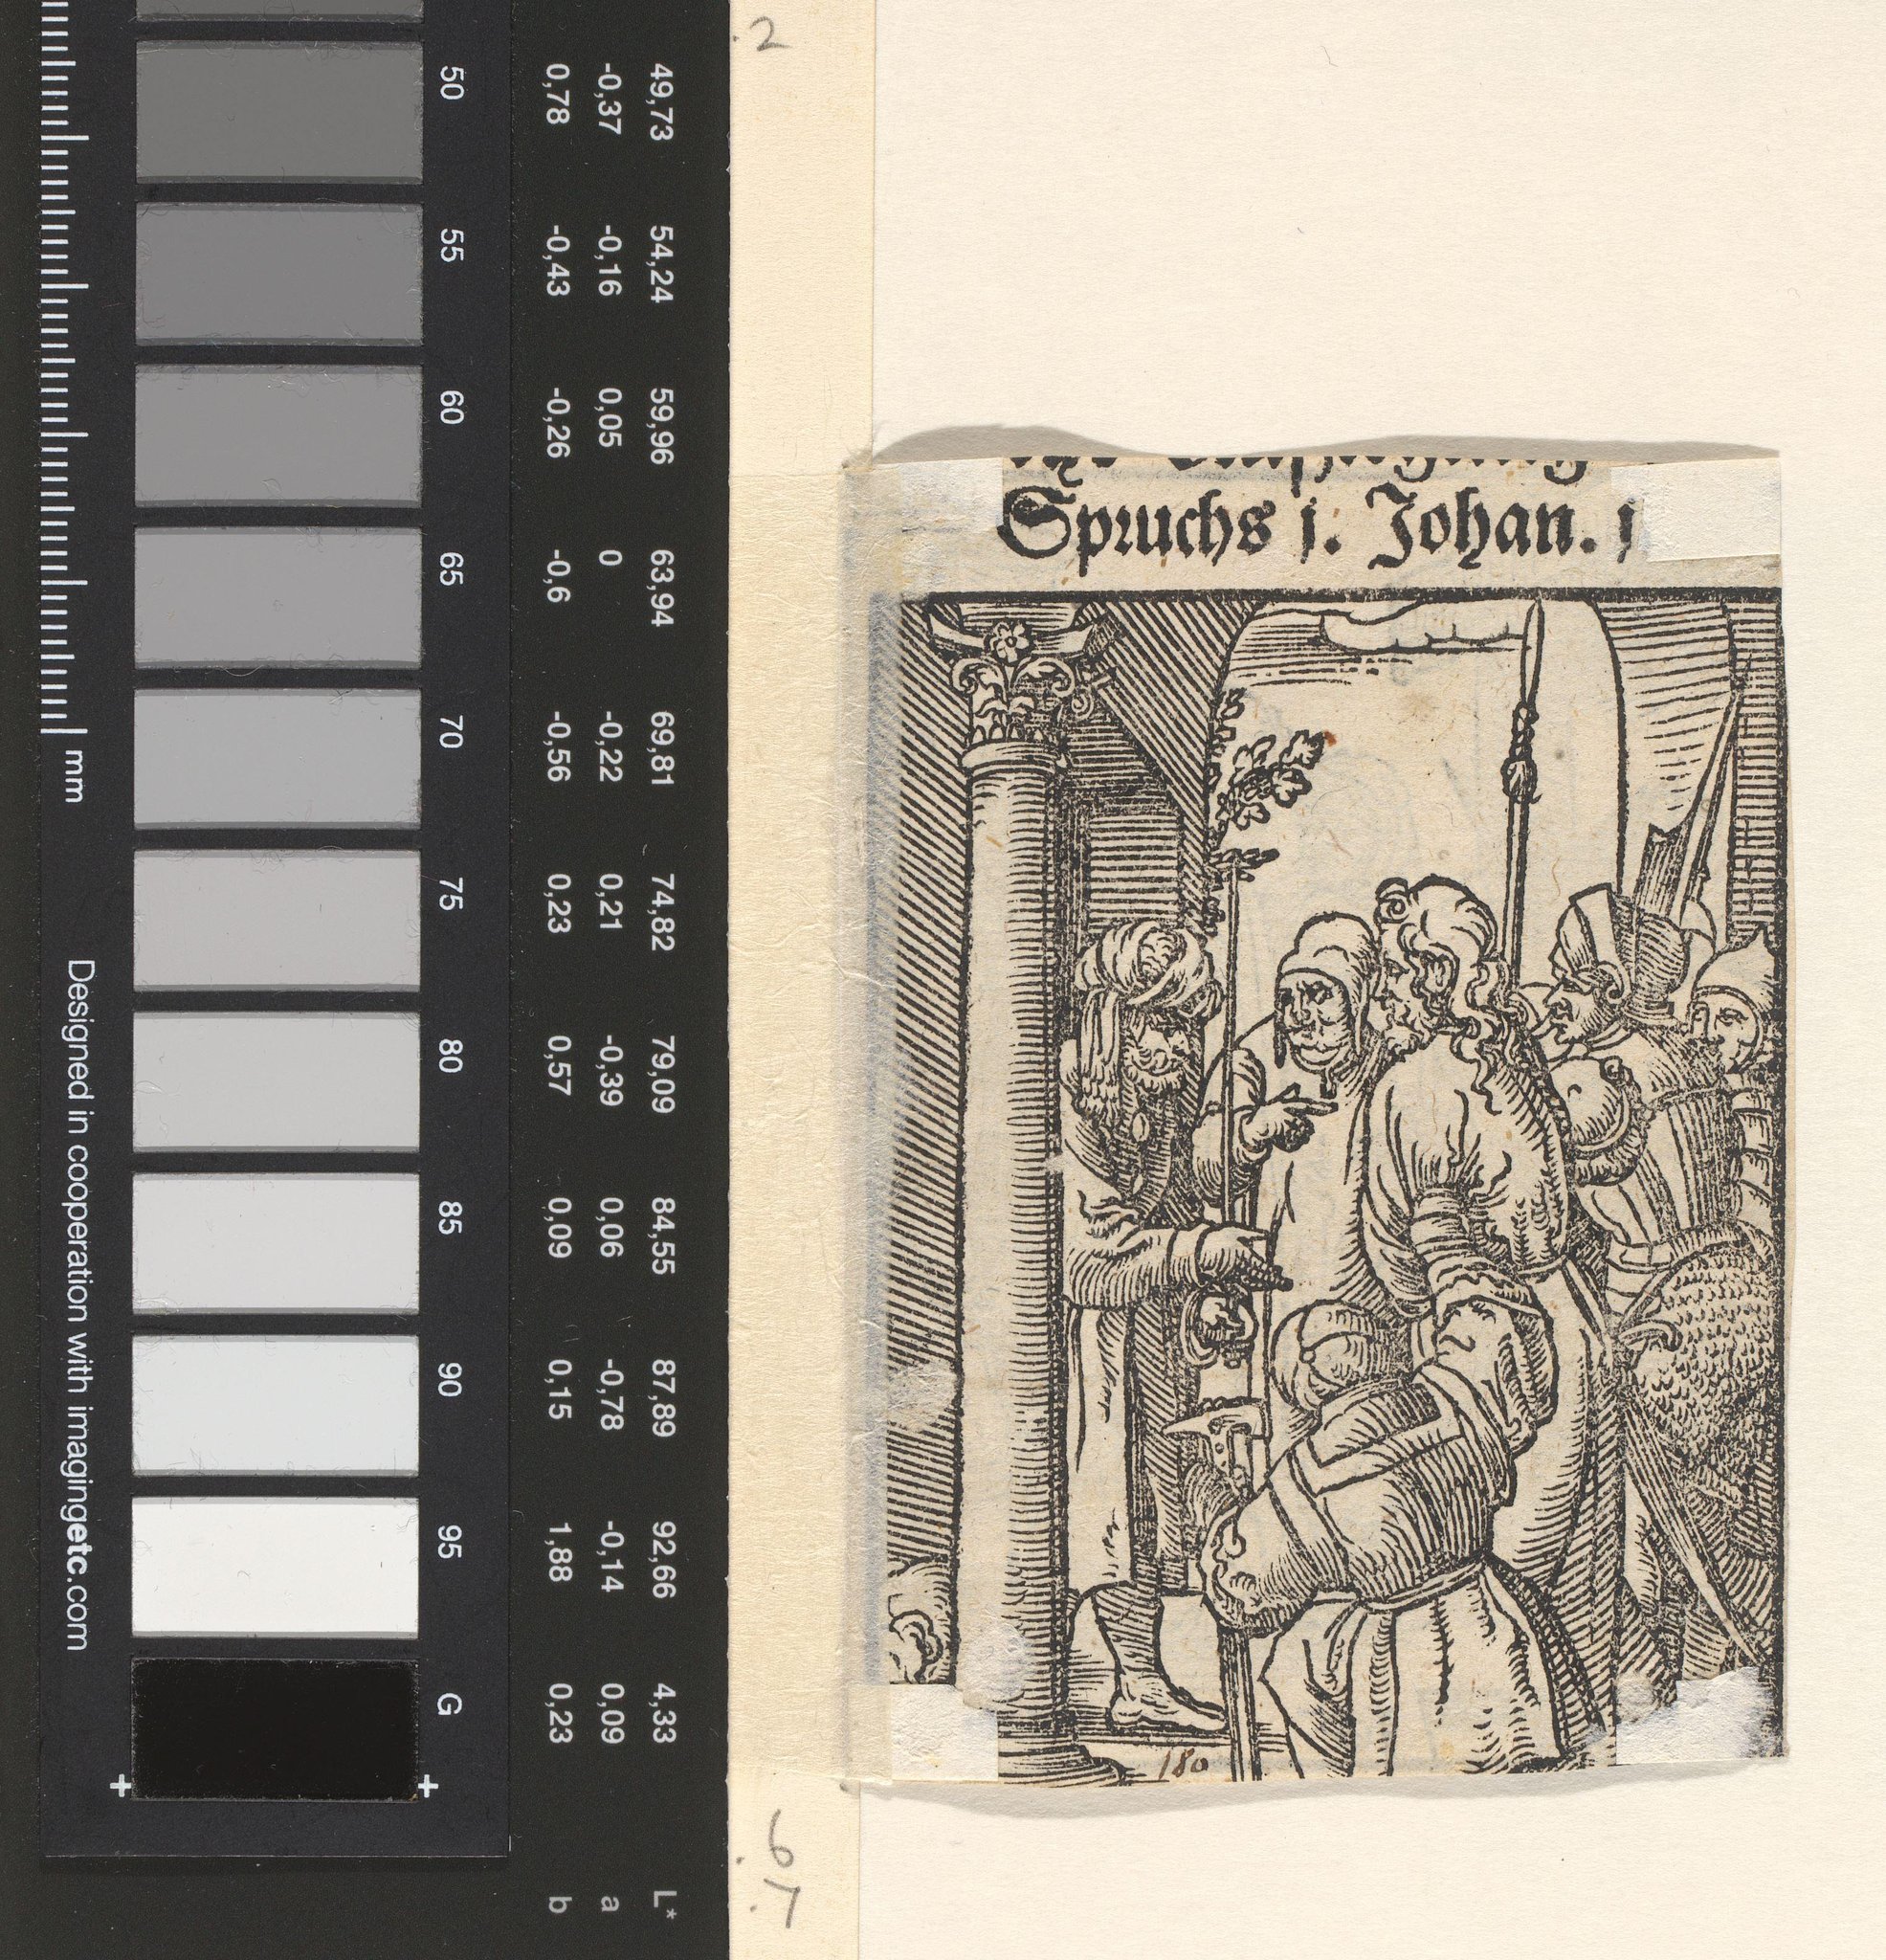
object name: book illustration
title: Christus voor Pilatus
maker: virgilius solis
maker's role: draughtsman, print maker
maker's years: 1514-1562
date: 1558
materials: paper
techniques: woodcut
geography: nuremberg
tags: christ before pontius pilate (matthew 27:11-26; mark 15:2-15; luke 23:2-7, 23:13-25; john 18:28 - 19:16)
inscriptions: number: ‘180’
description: Gebruikt voor de publicatie: Rhau, Georg. Hortulus Animae. Neurenberg: Valentin Geißler, 1558.